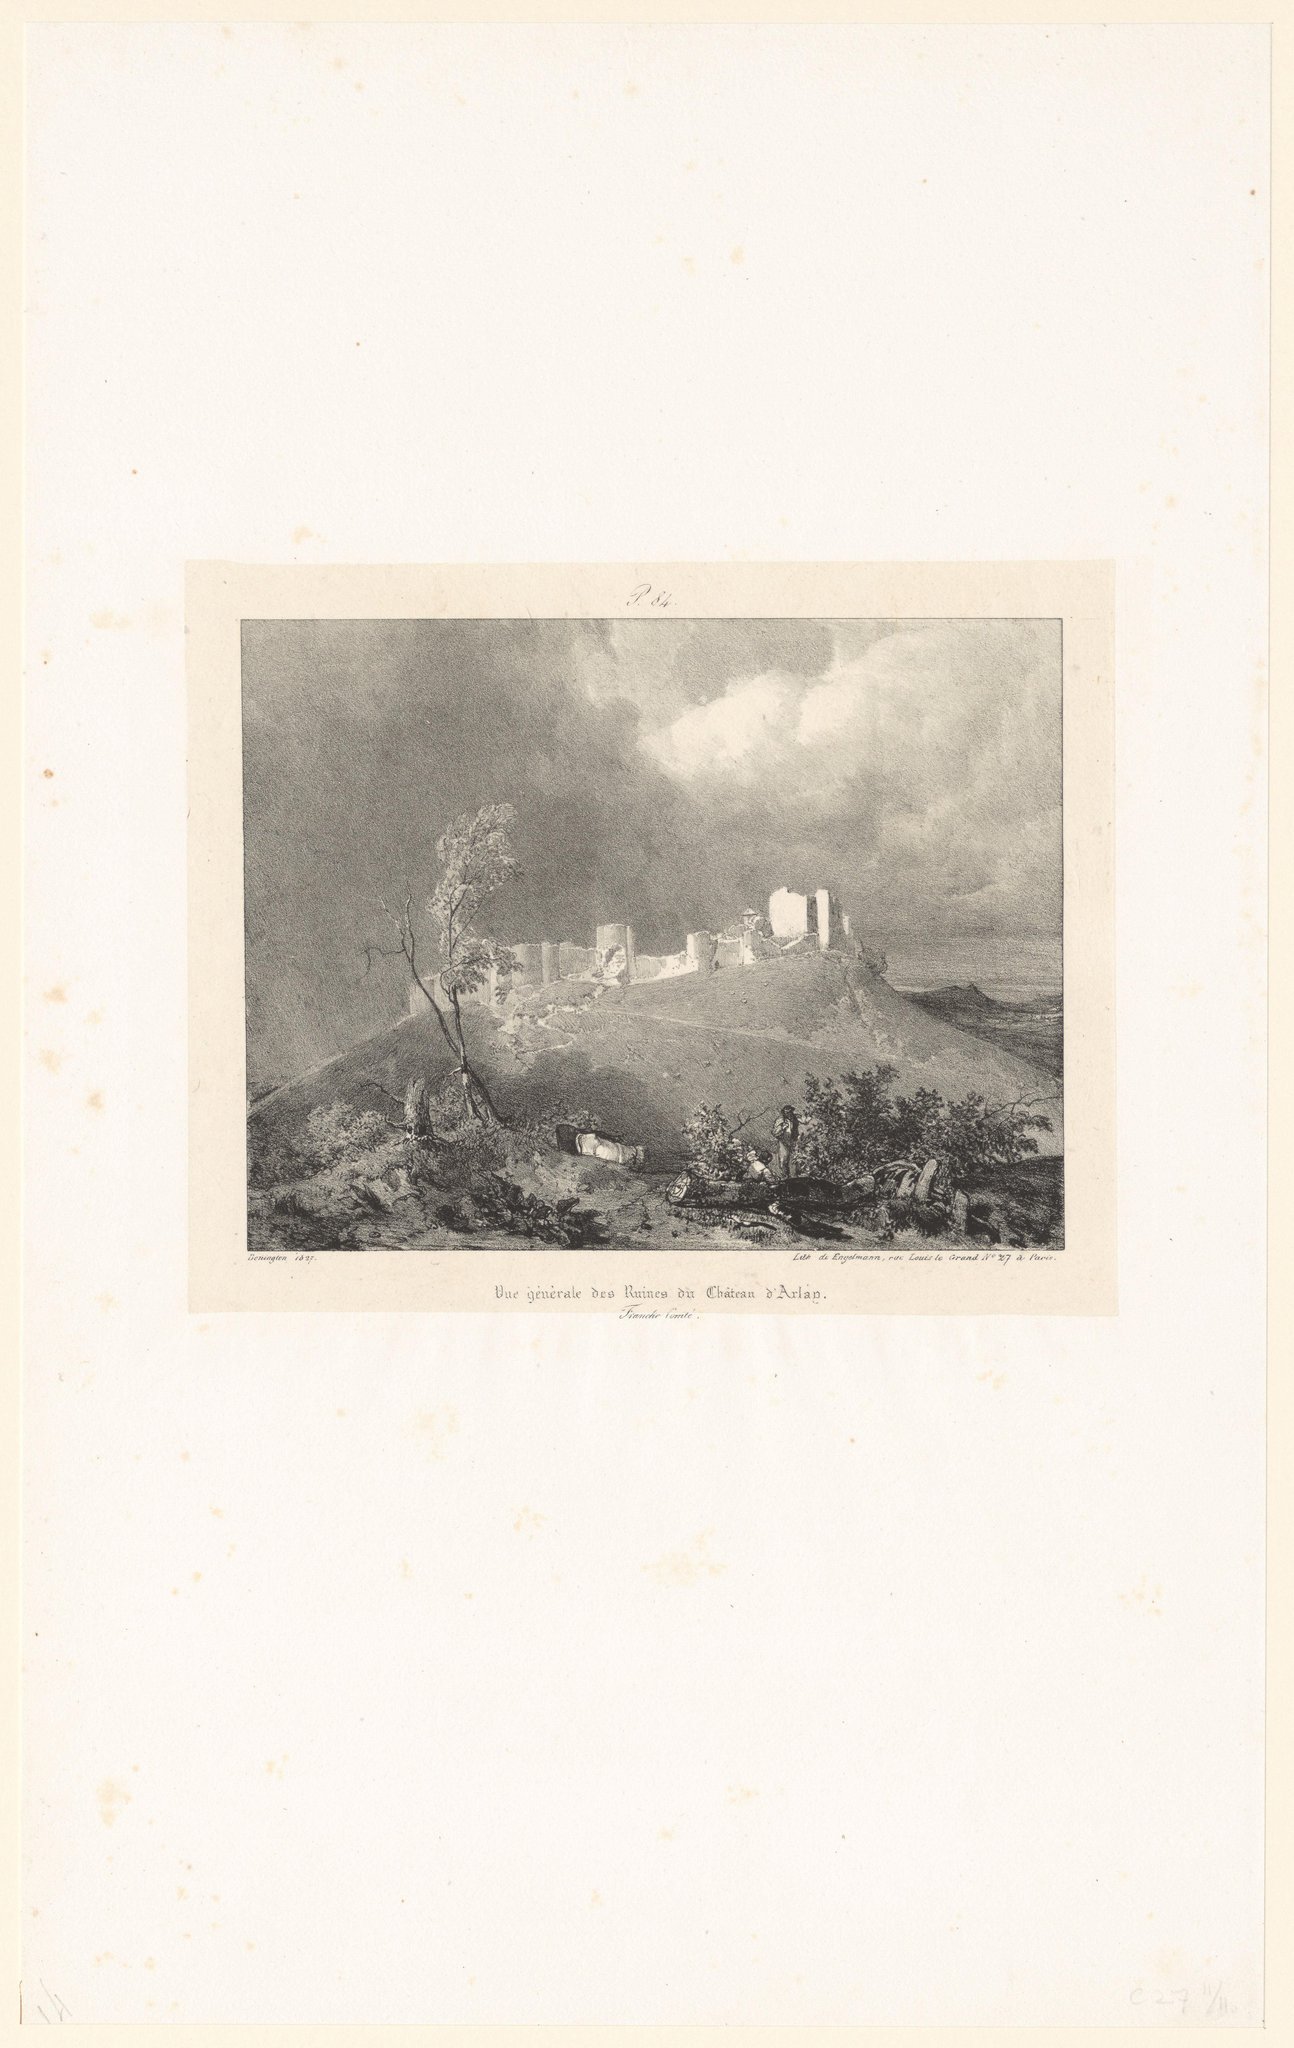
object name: print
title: Vue générale des Ruines du Château d'Arlay, Franche Comté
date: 1827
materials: paper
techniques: lithograph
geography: paris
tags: landscape with ruins, ruin of a dwelling, house, castle, etc., france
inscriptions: collector's mark: Lugt 2228, collector's mark: Lugt 2760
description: Deze prent behoort tot de serie 'Voyages pittoresques et romantiques dans l'ancienne France'. De serie is uitgevoerd onder leiding van Isidore Justin Séverin baron Taylor en bevat begeleidende teksten van Charles Nodier en Alphonse de Cailleux. Voor het project zijn vele kunstenaars naar delen van Frankrijk afgereisd. De reeks is tussen 1821 en 1878 in ca. 21 delen gepubliceerd.